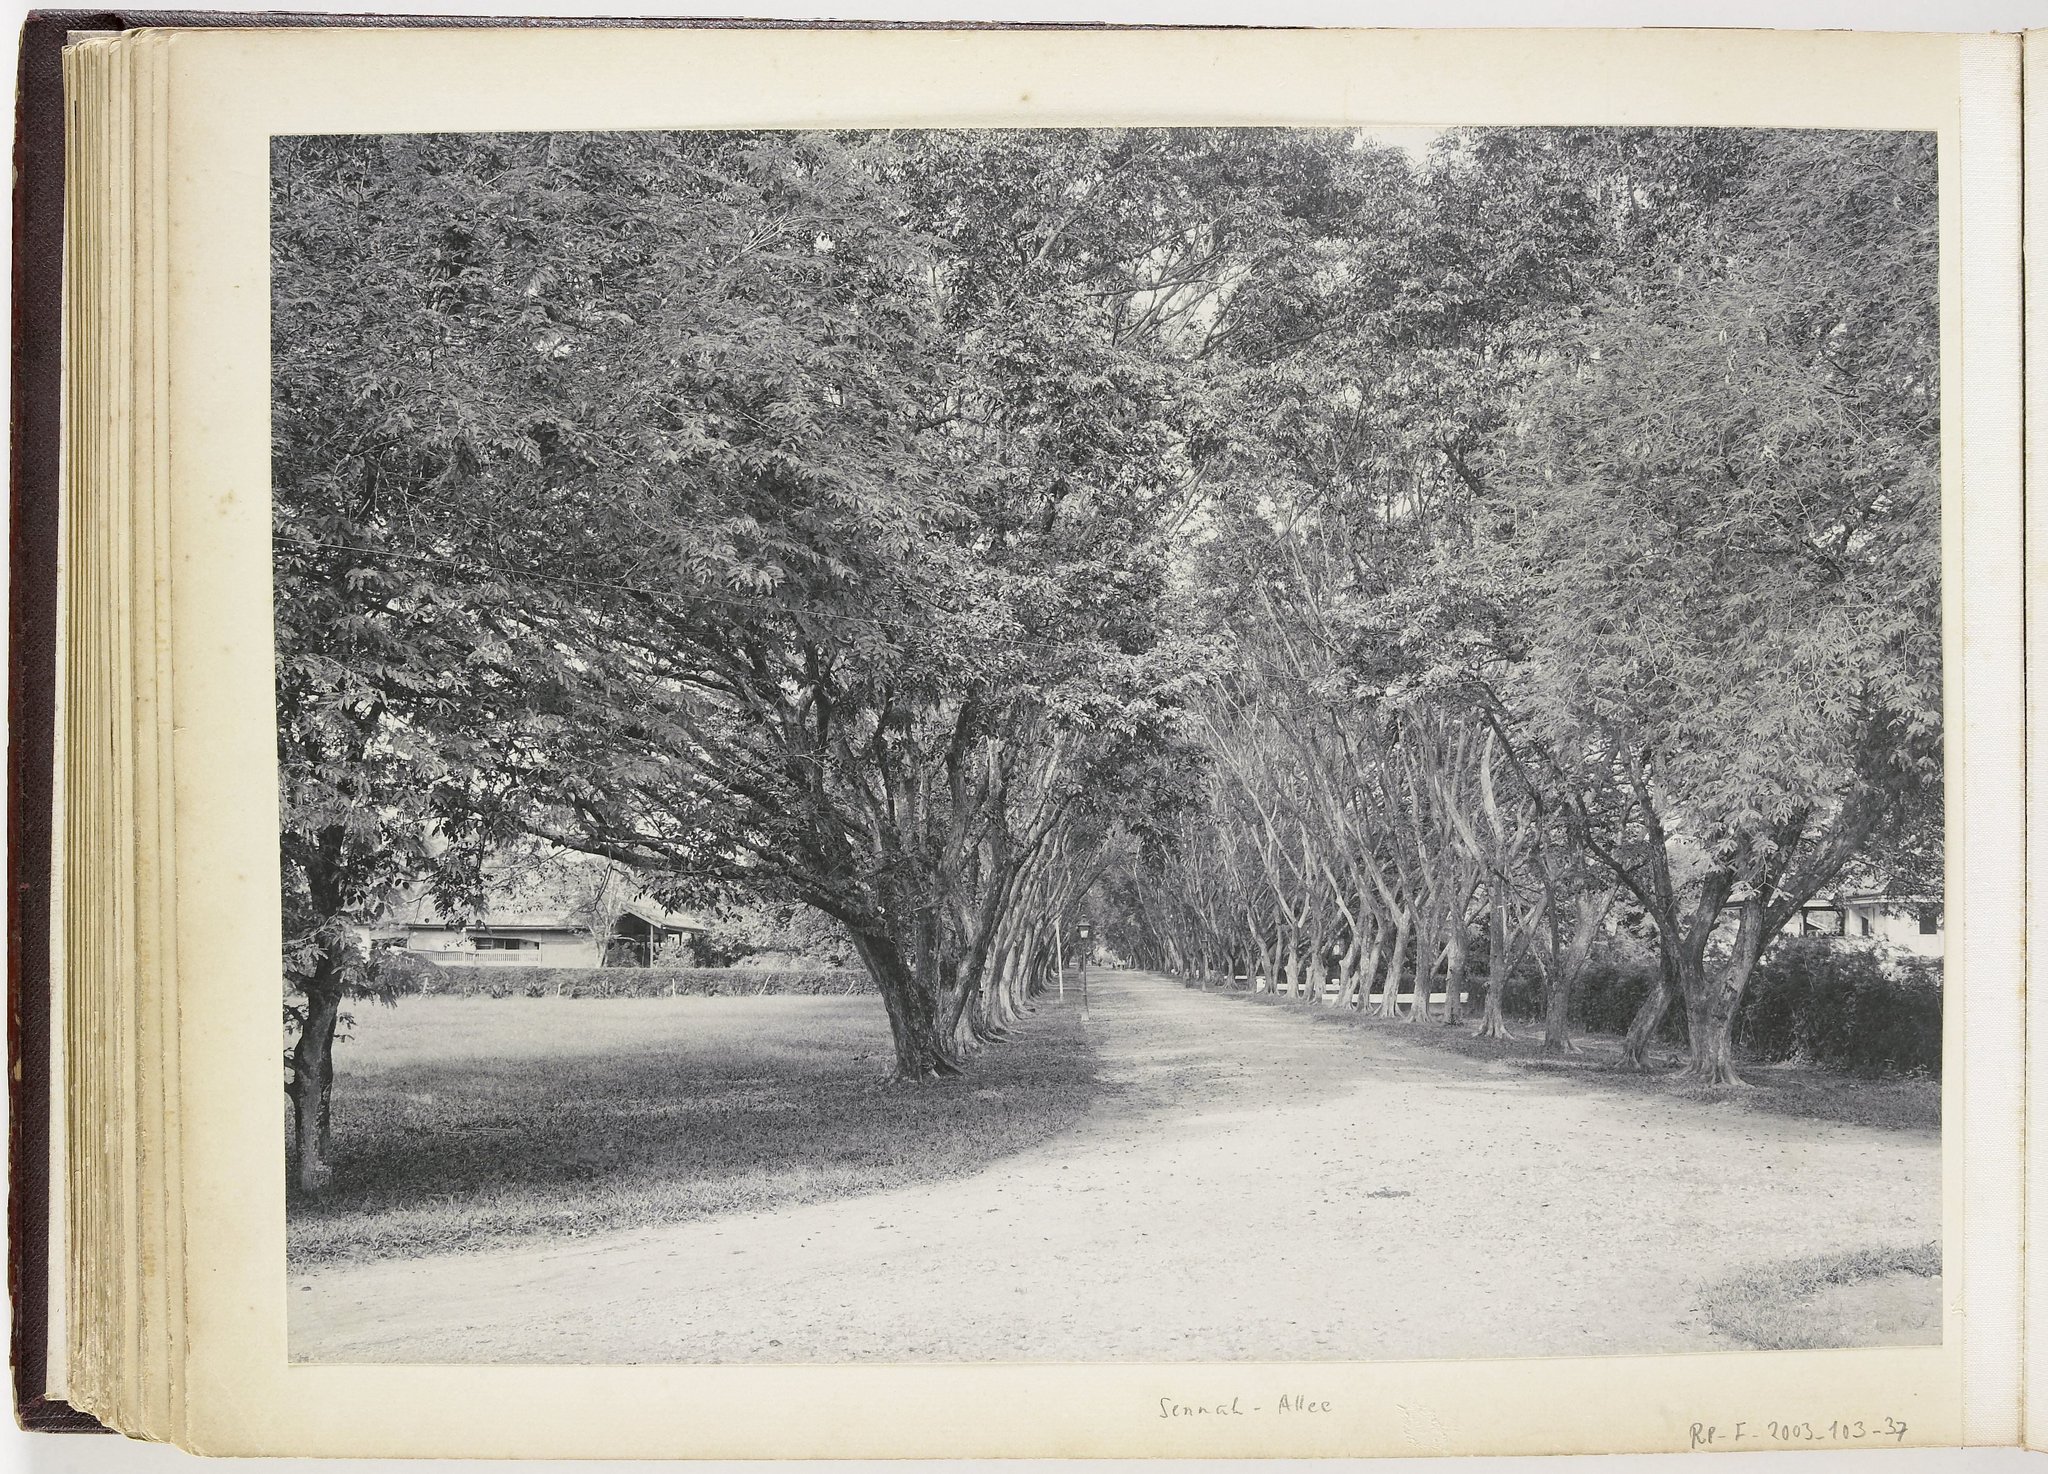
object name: photograph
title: Gezicht in de Sennah Allee, Langkat Sumatra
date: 1900-1905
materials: cardboard, paper, photographic support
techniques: platinum process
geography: bindjai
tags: sumatra